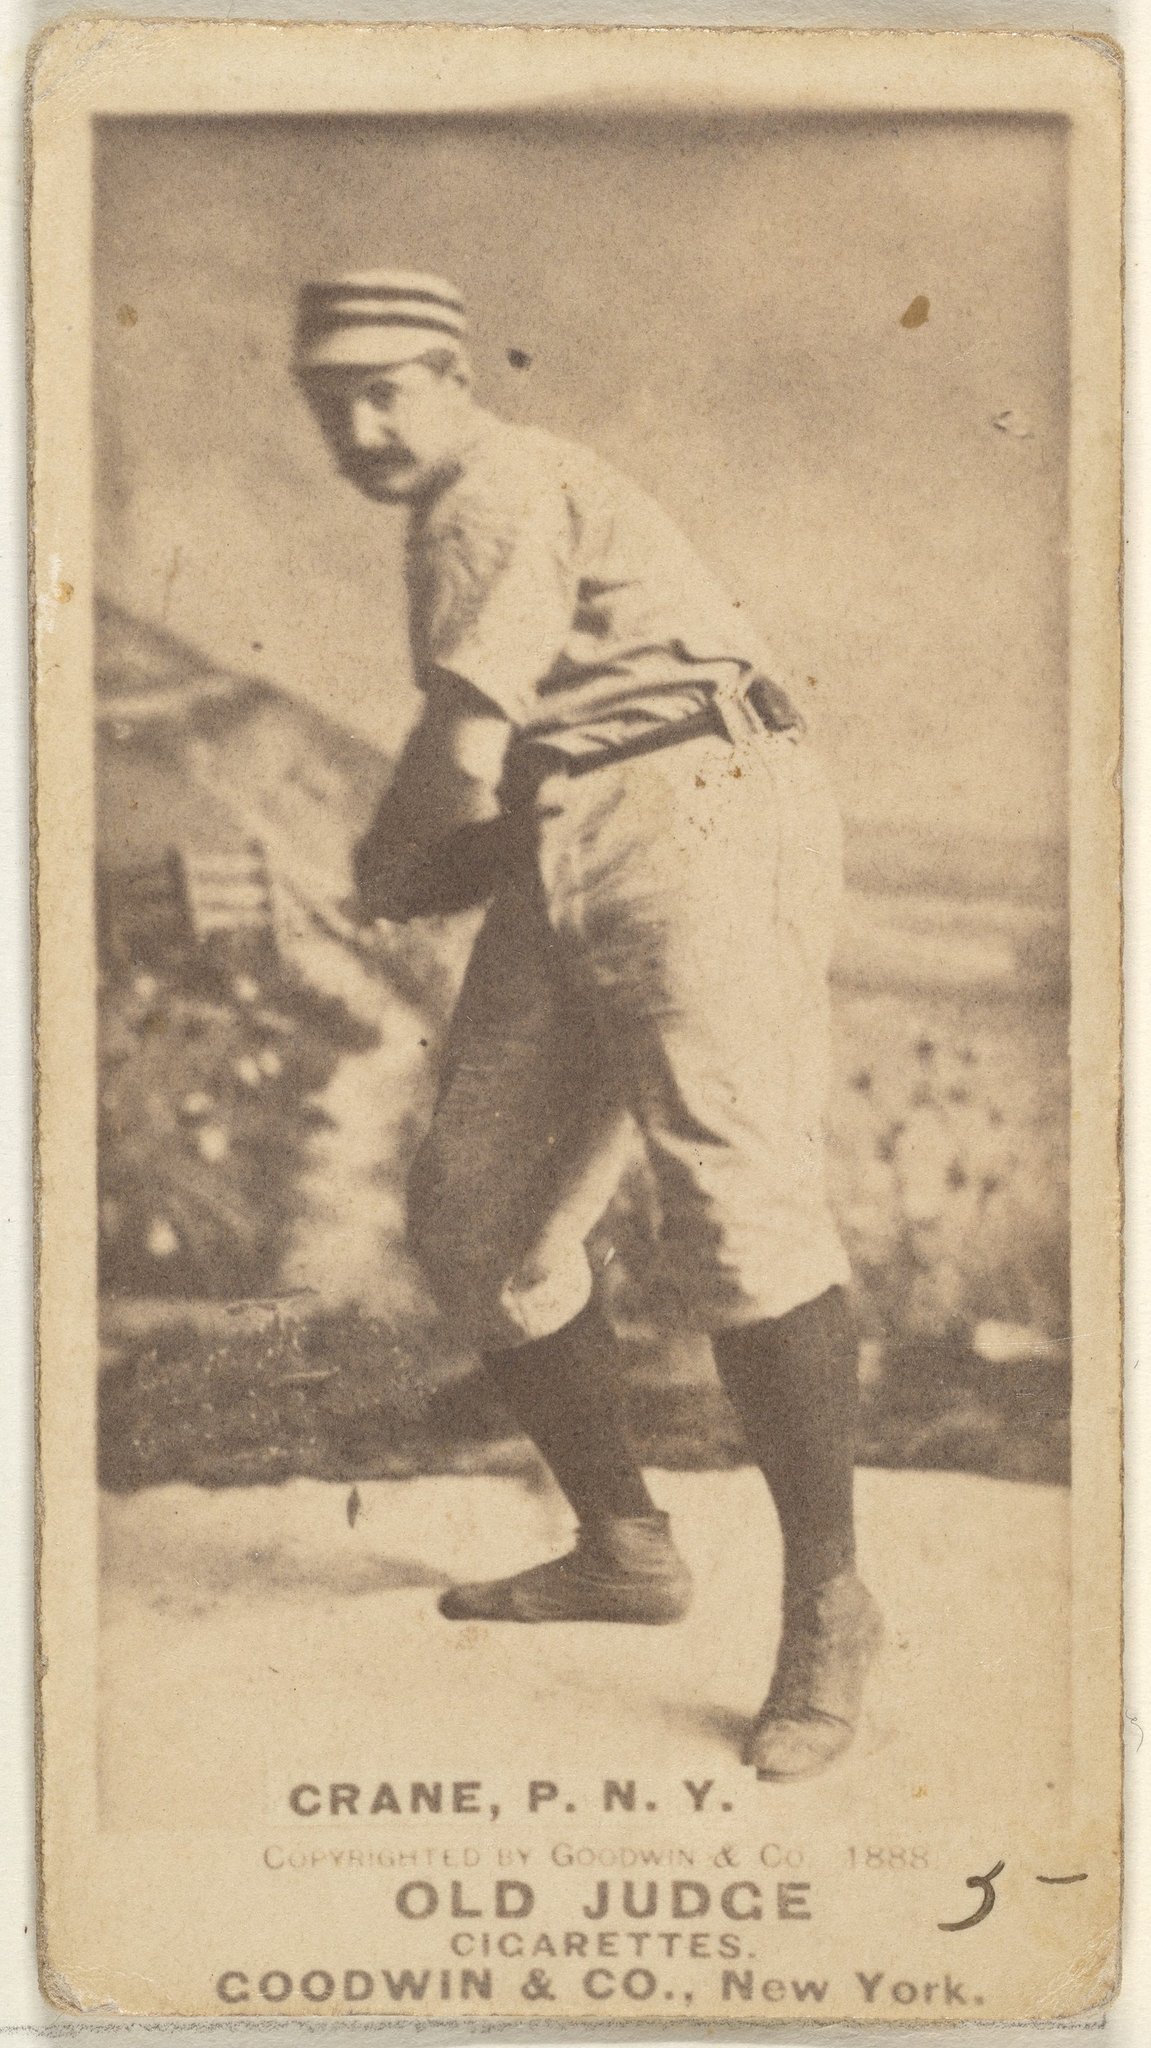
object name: baseball card, photograph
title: Ed Crane, Pitcher, New York, from the Old Judge series (N172) for Old Judge Cigarettes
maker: goodwin & company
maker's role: publisher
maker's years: 1850-1950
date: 1888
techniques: albumen silver print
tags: men,portraits,baseball,athletes